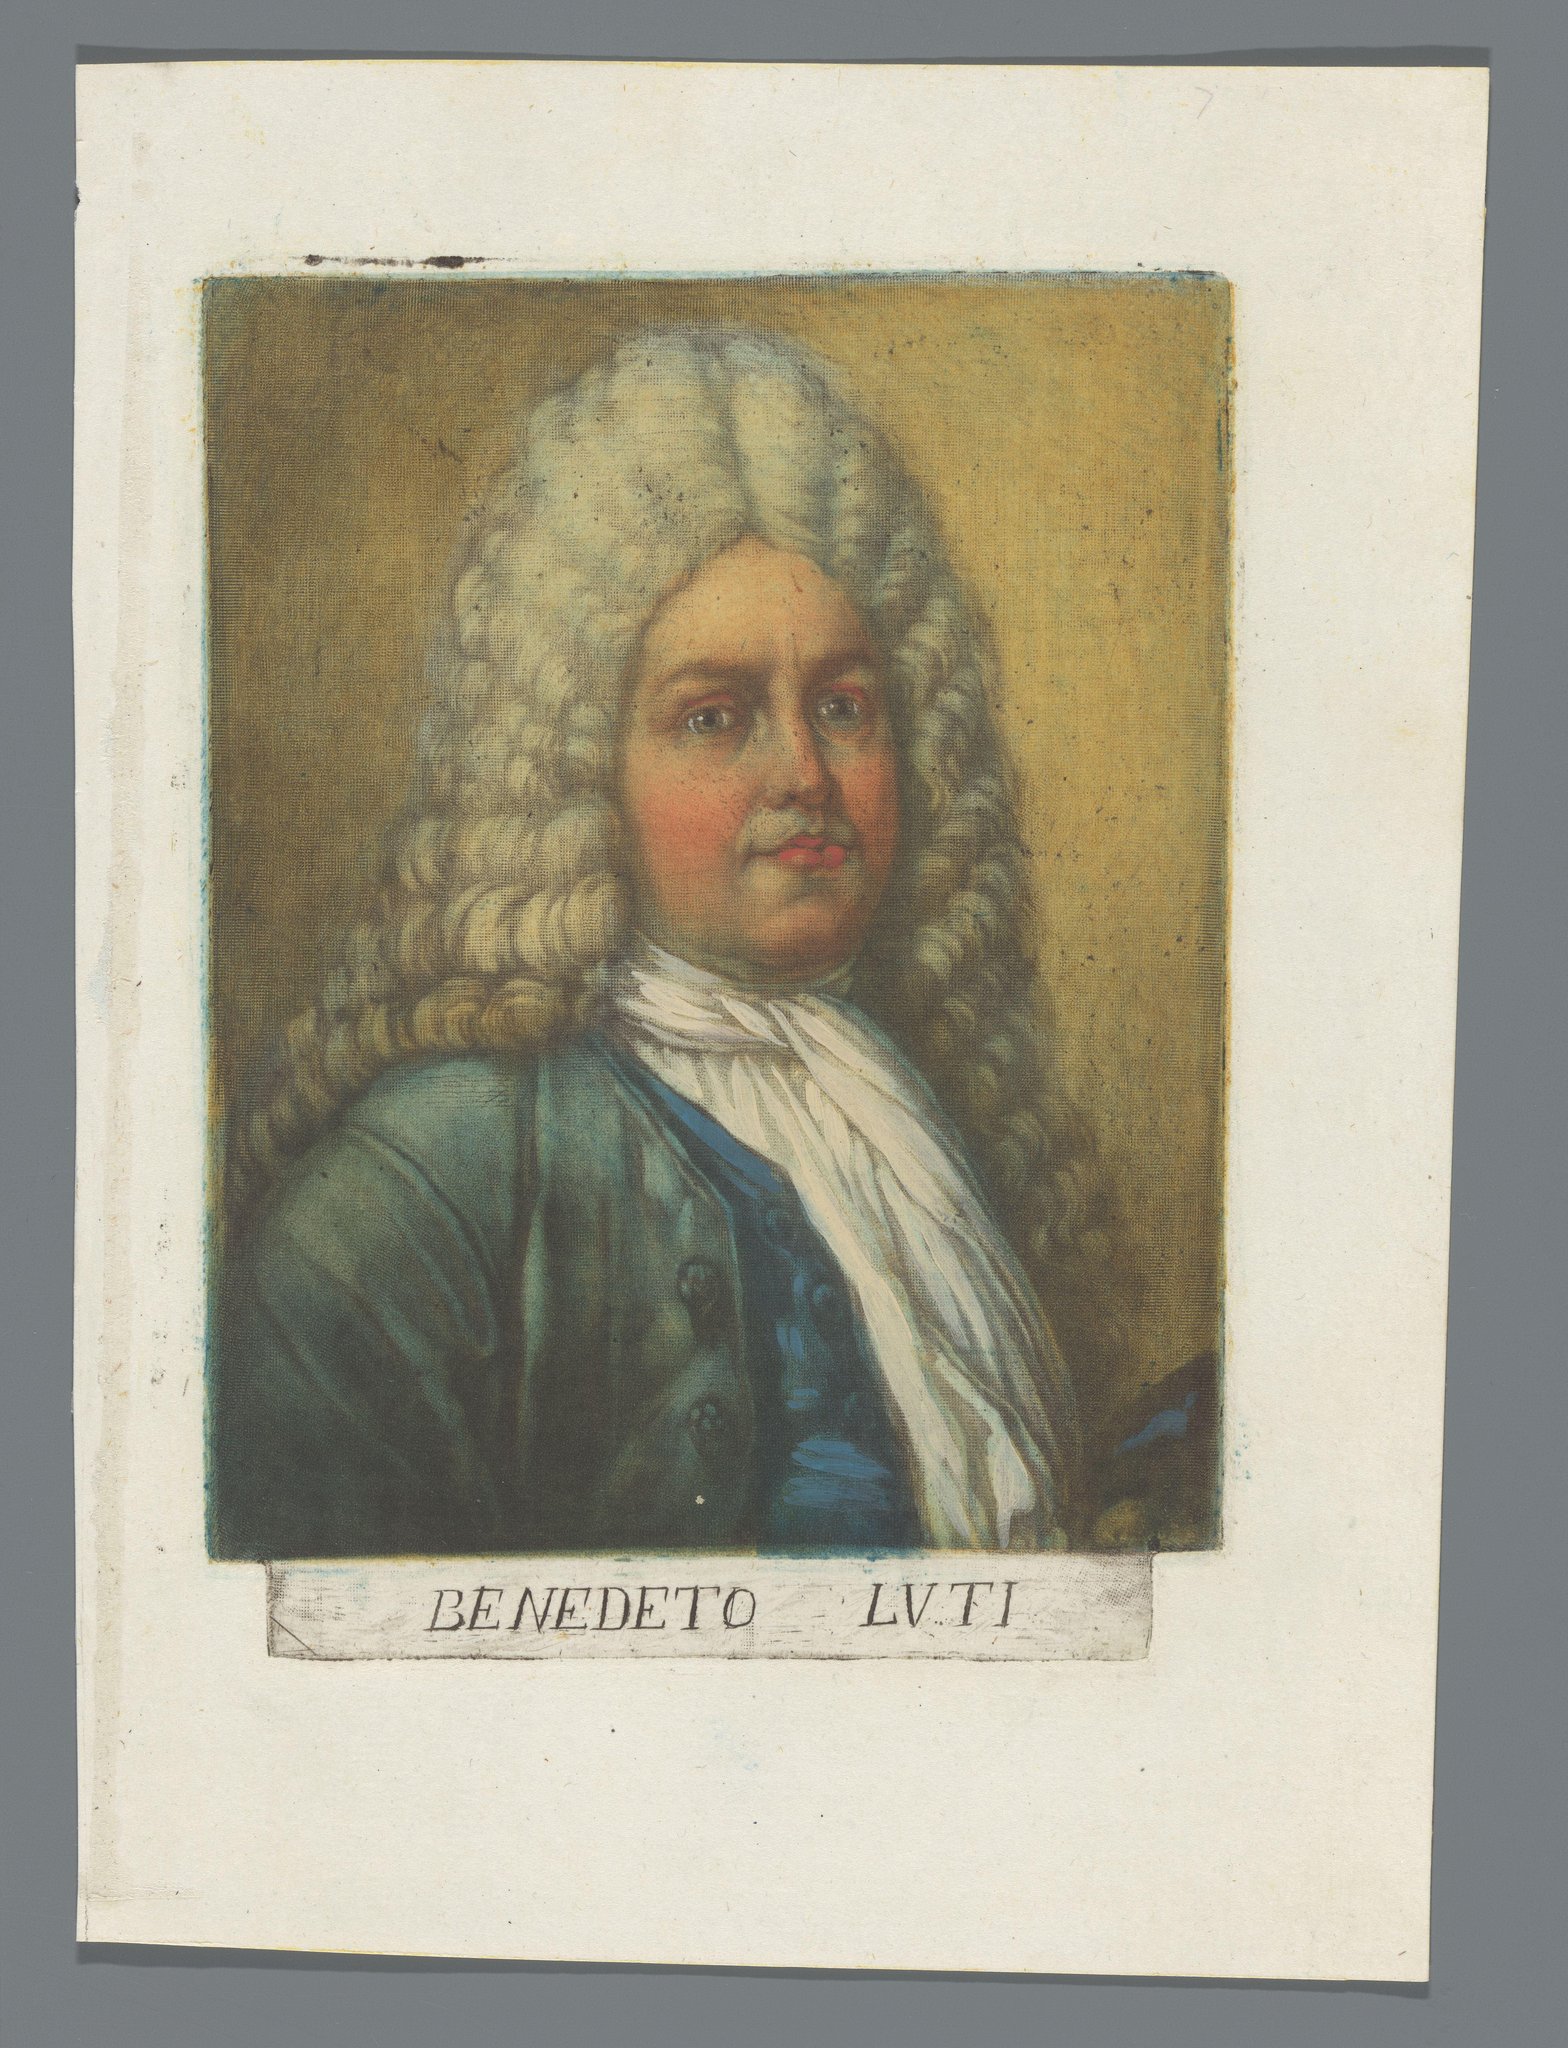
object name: print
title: Portret van Benedetto Luti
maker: carlo lasinio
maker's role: painter, print maker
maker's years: 1759-1838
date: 1789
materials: gouache, paper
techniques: color mezzotint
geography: florence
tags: rome, draughtsman, benedetto luti, historical persons, portrait, self-portrait of painter, portrait, self-portrait of artist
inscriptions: number: ‘65’, collector's mark: Lugt 2228, inscription:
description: Een prent uit een groep van veertig kleurendrukken met kunstenaarsportretten, gebaseerd op de collectie geschilderde zelfportretten van kunstenaars verzameld door de Medici in Florence. De groep maakt deel uit van het grote werk van Lasinio ‘Gli Autoritratti della Real Galleria di Firenze’, uitgegeven in 1789 met omstreeks 350 kunstenaarsportretten. Van deze uitgave is tot nog toe is geen compleet exemplaar bekend. In de inspringende marges onderaan de prenten zijn de namen van de kunstenaars aangebracht en soms hun levensdata en de plaats van geboorte en sterven en een enkele maal de signatuur van Lasinio en dat van de drukker Labrelis. Getuige de bindgaatjes en lijmresten moeten de prenten ingebonden zijn geweest in een album. De meeste prenten zijn verso voorzien van nummers in potlood, met als laagste nummer 2 en hoogste 93. Tevens zijn er verso Italiaanse opschriften in pen aangebracht met de levensdata van de kunstenaars en de school waartoe zij worden gerekend. Deze opschriften zijn vrijwel alle deels afgesneden. Elf prenten zijn niet genummerd en niet voorzien van opschriften. Deze laatste elf zijn alle gedrukt op blauw papier.